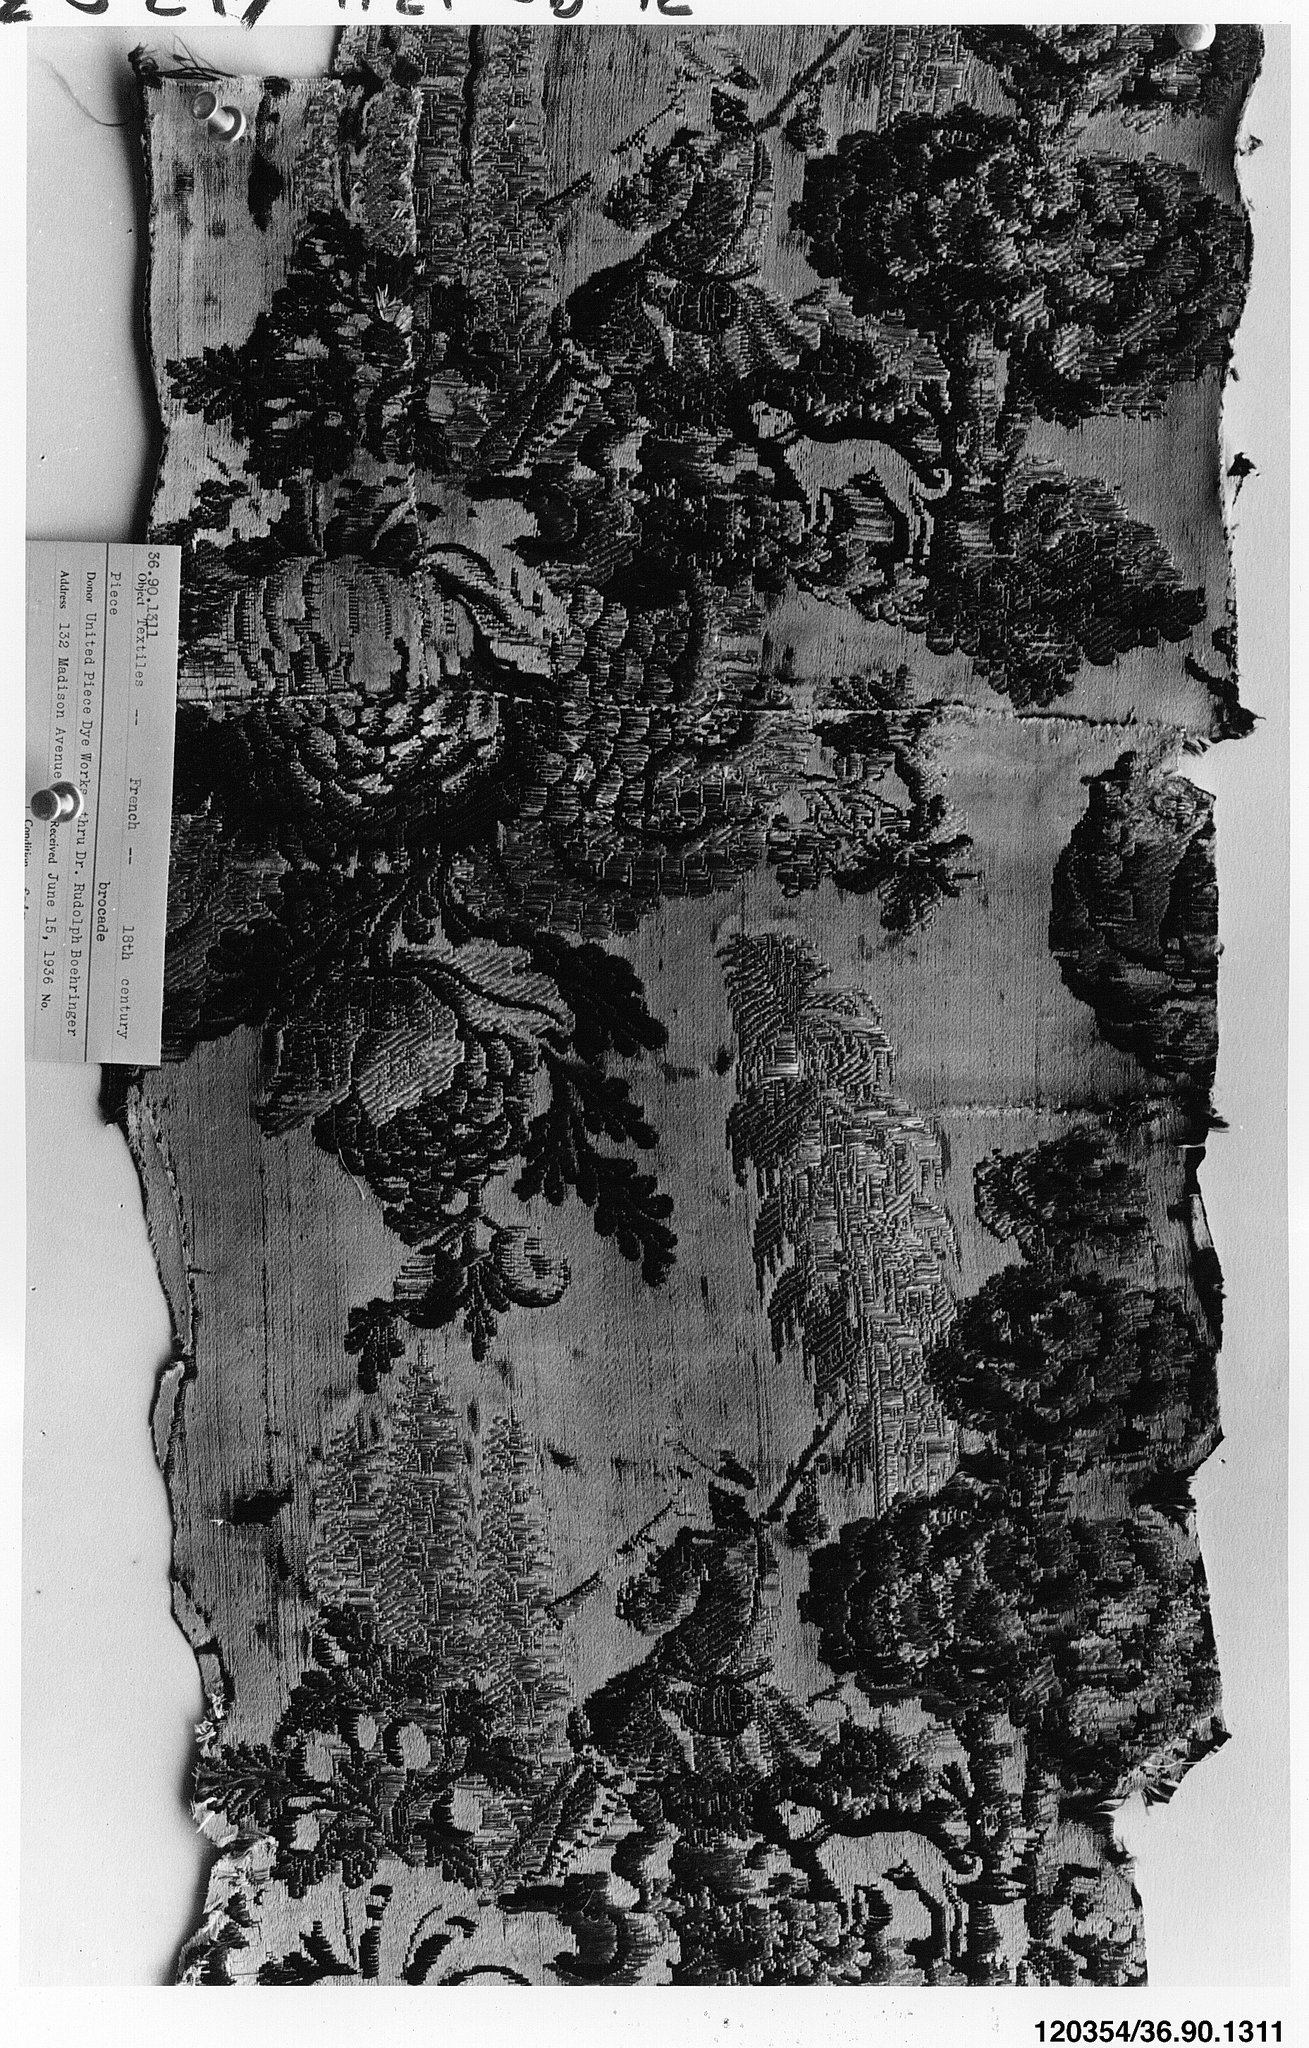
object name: piece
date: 1735-1740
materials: metal thread, silk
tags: flowers,leaves